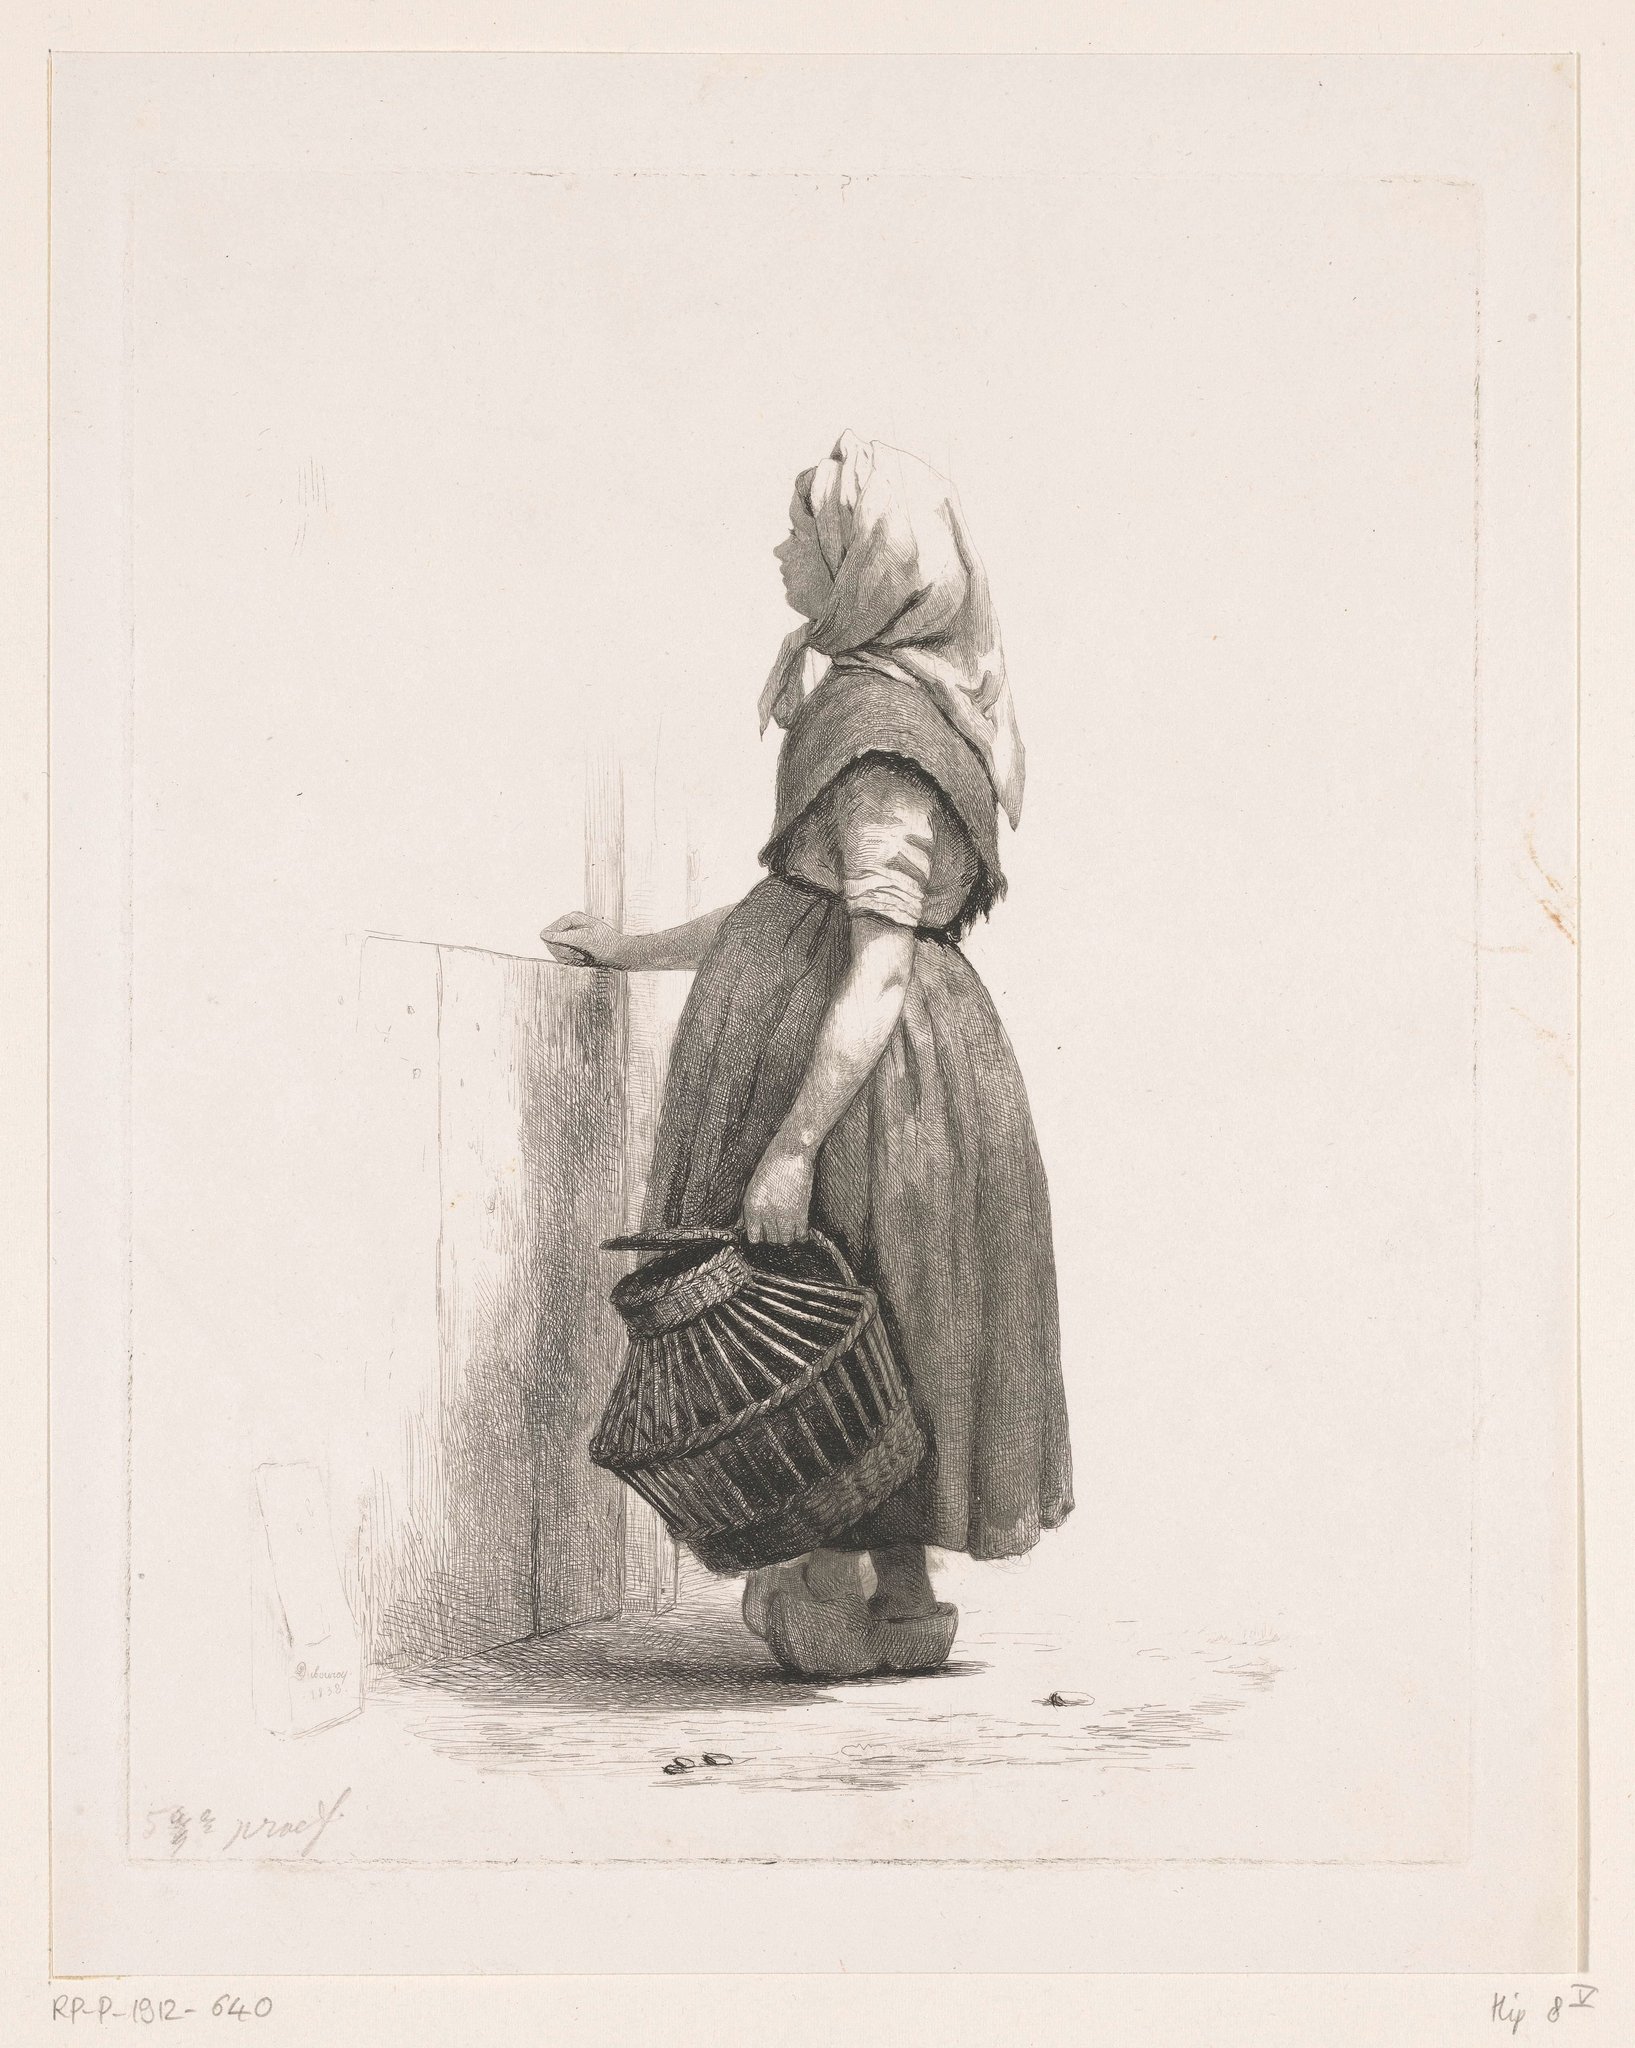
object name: print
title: Vijf etsproeven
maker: pierre louis dubourcq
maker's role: draughtsman, painter, print maker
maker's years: 1815-1873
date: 1838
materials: paper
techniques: drypoint, etching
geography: netherlands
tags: fowl (cock, hen, chicken, etc.) (+ animal cage)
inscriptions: collector's mark: Lugt 2228